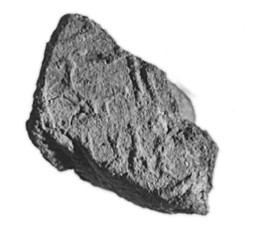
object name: sealing fragment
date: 2030-1640 BCE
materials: clay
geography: egypt